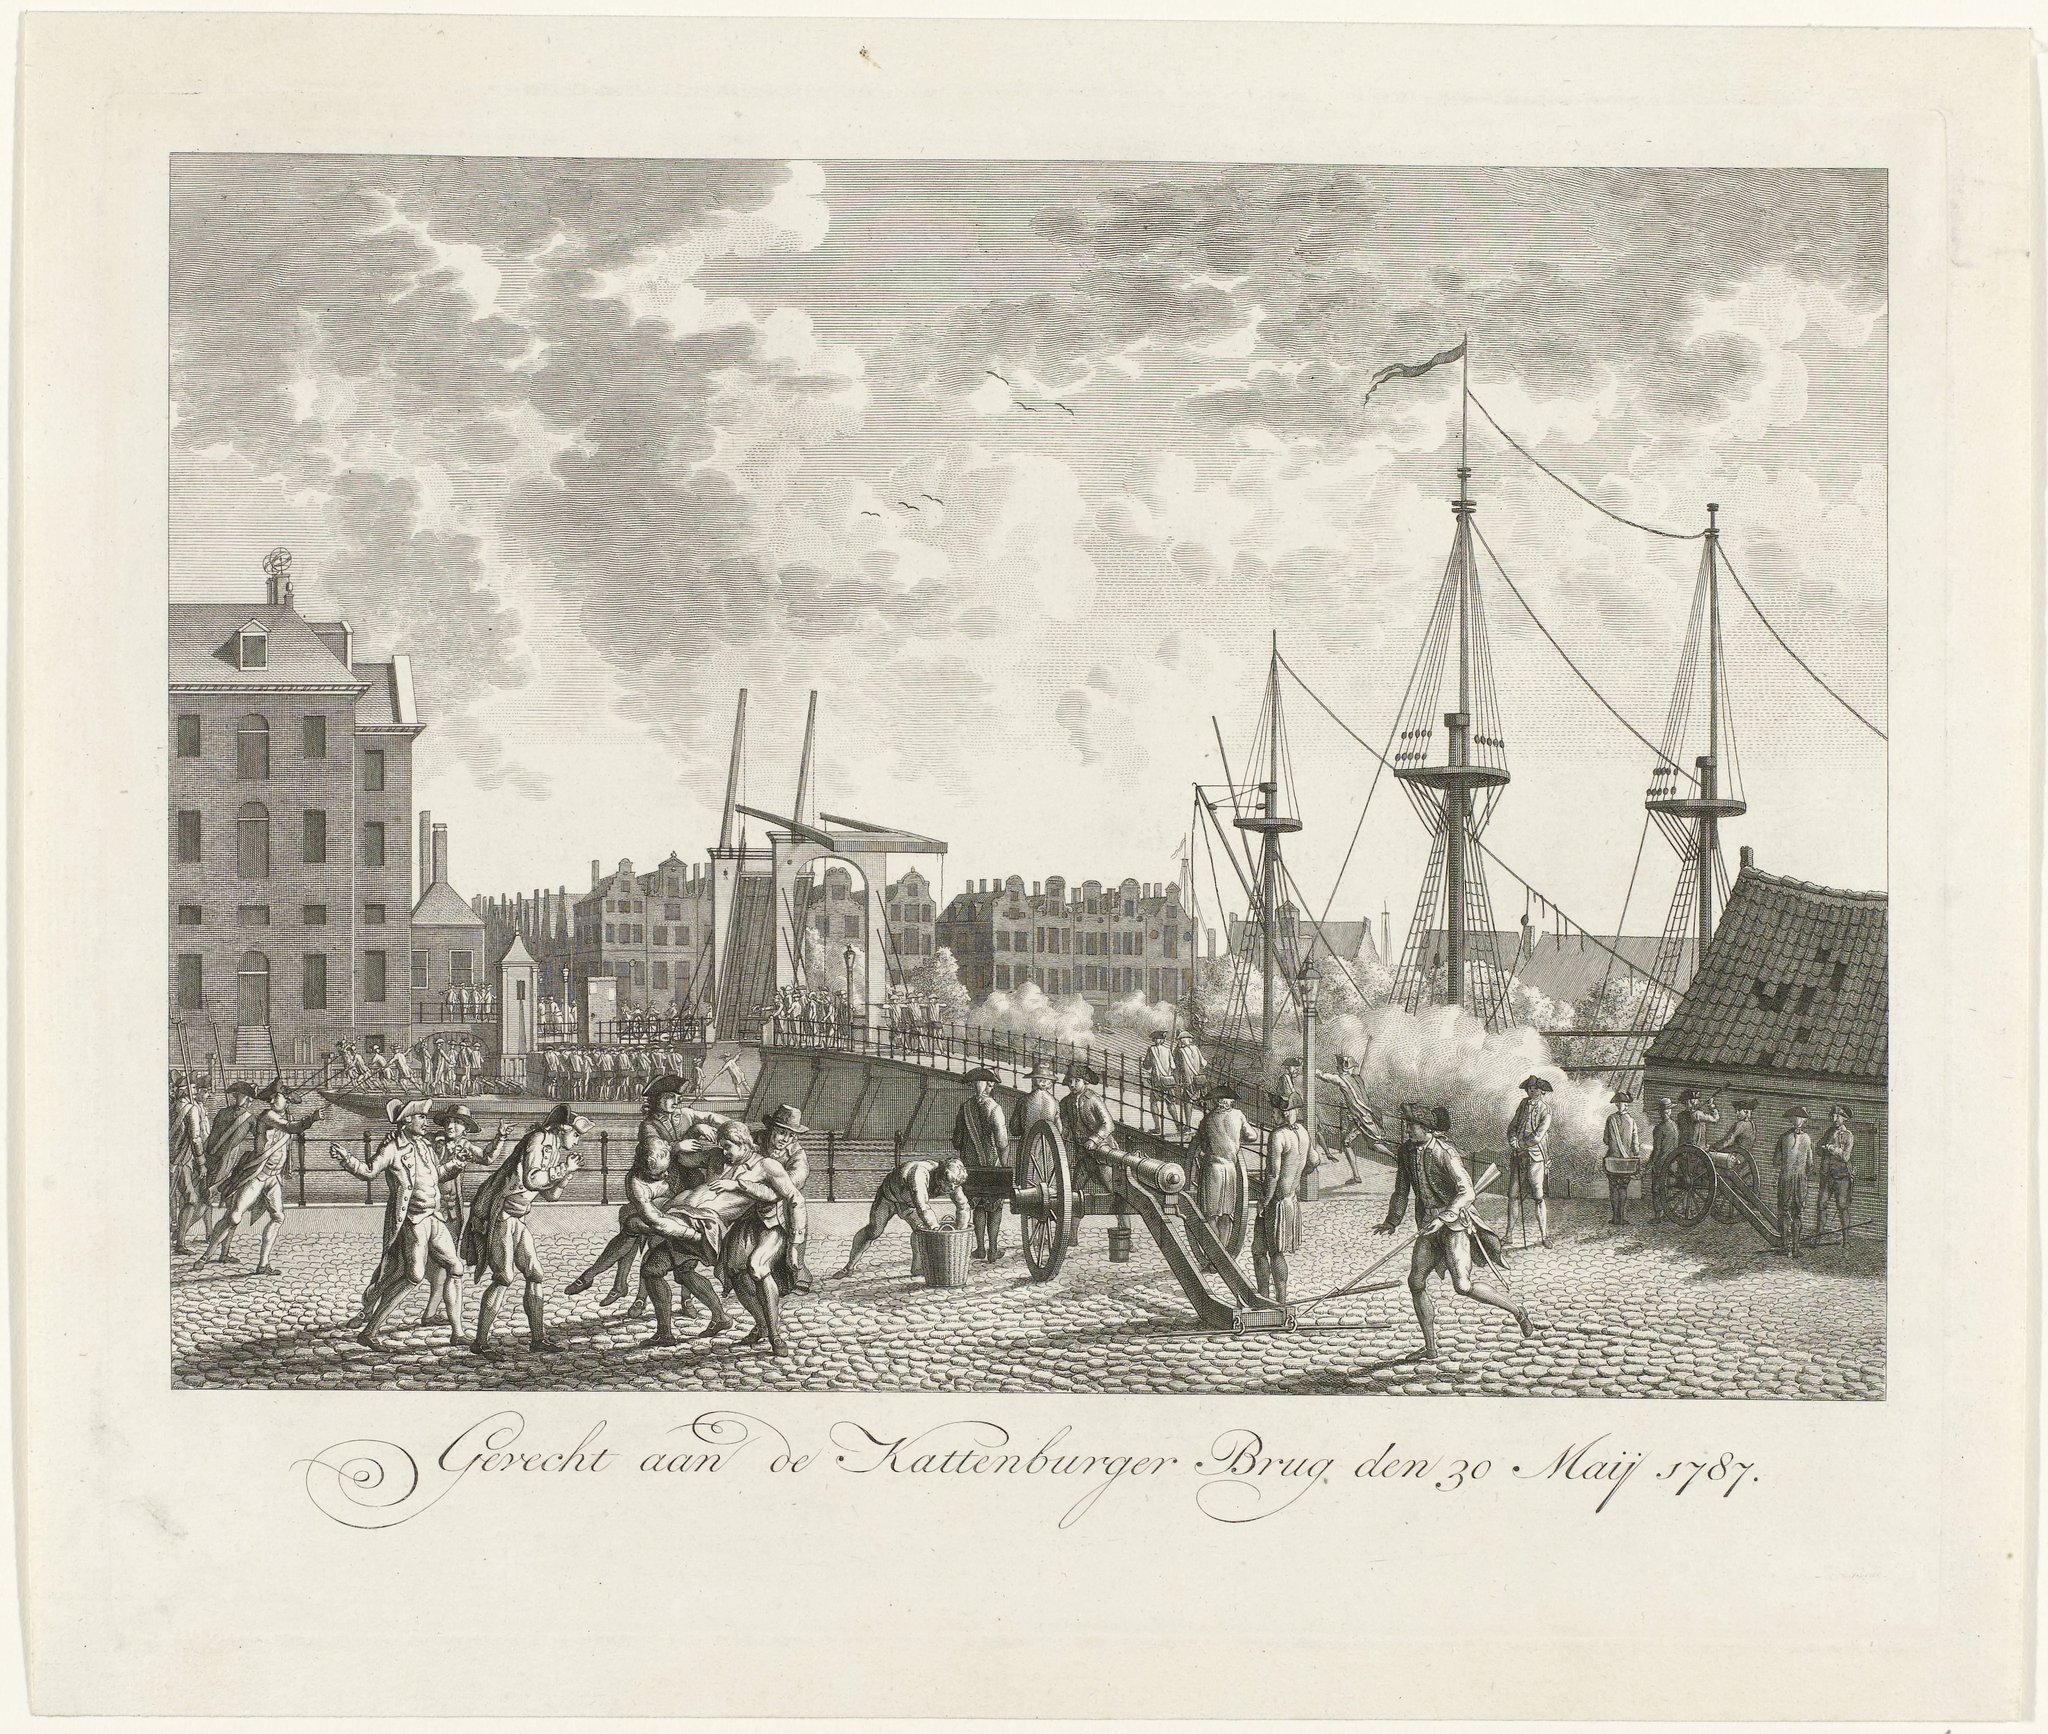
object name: print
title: Verovering van de Kattenburgerbrug, 1787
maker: Anonymous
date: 1787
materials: paper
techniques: engraving, etching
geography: northern netherlands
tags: battle (+ citizen soldiery, civil guard, citizen militia)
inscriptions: collector's mark: Lugt 2228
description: De verovering van de Kattenburgerbrug naar het eiland Kattenburg op de opstandige Oranjegezinden door de gewapende Amsterdamse burgers, 30 mei 1787. Links een deel van 's Lands Zeemagazijn.